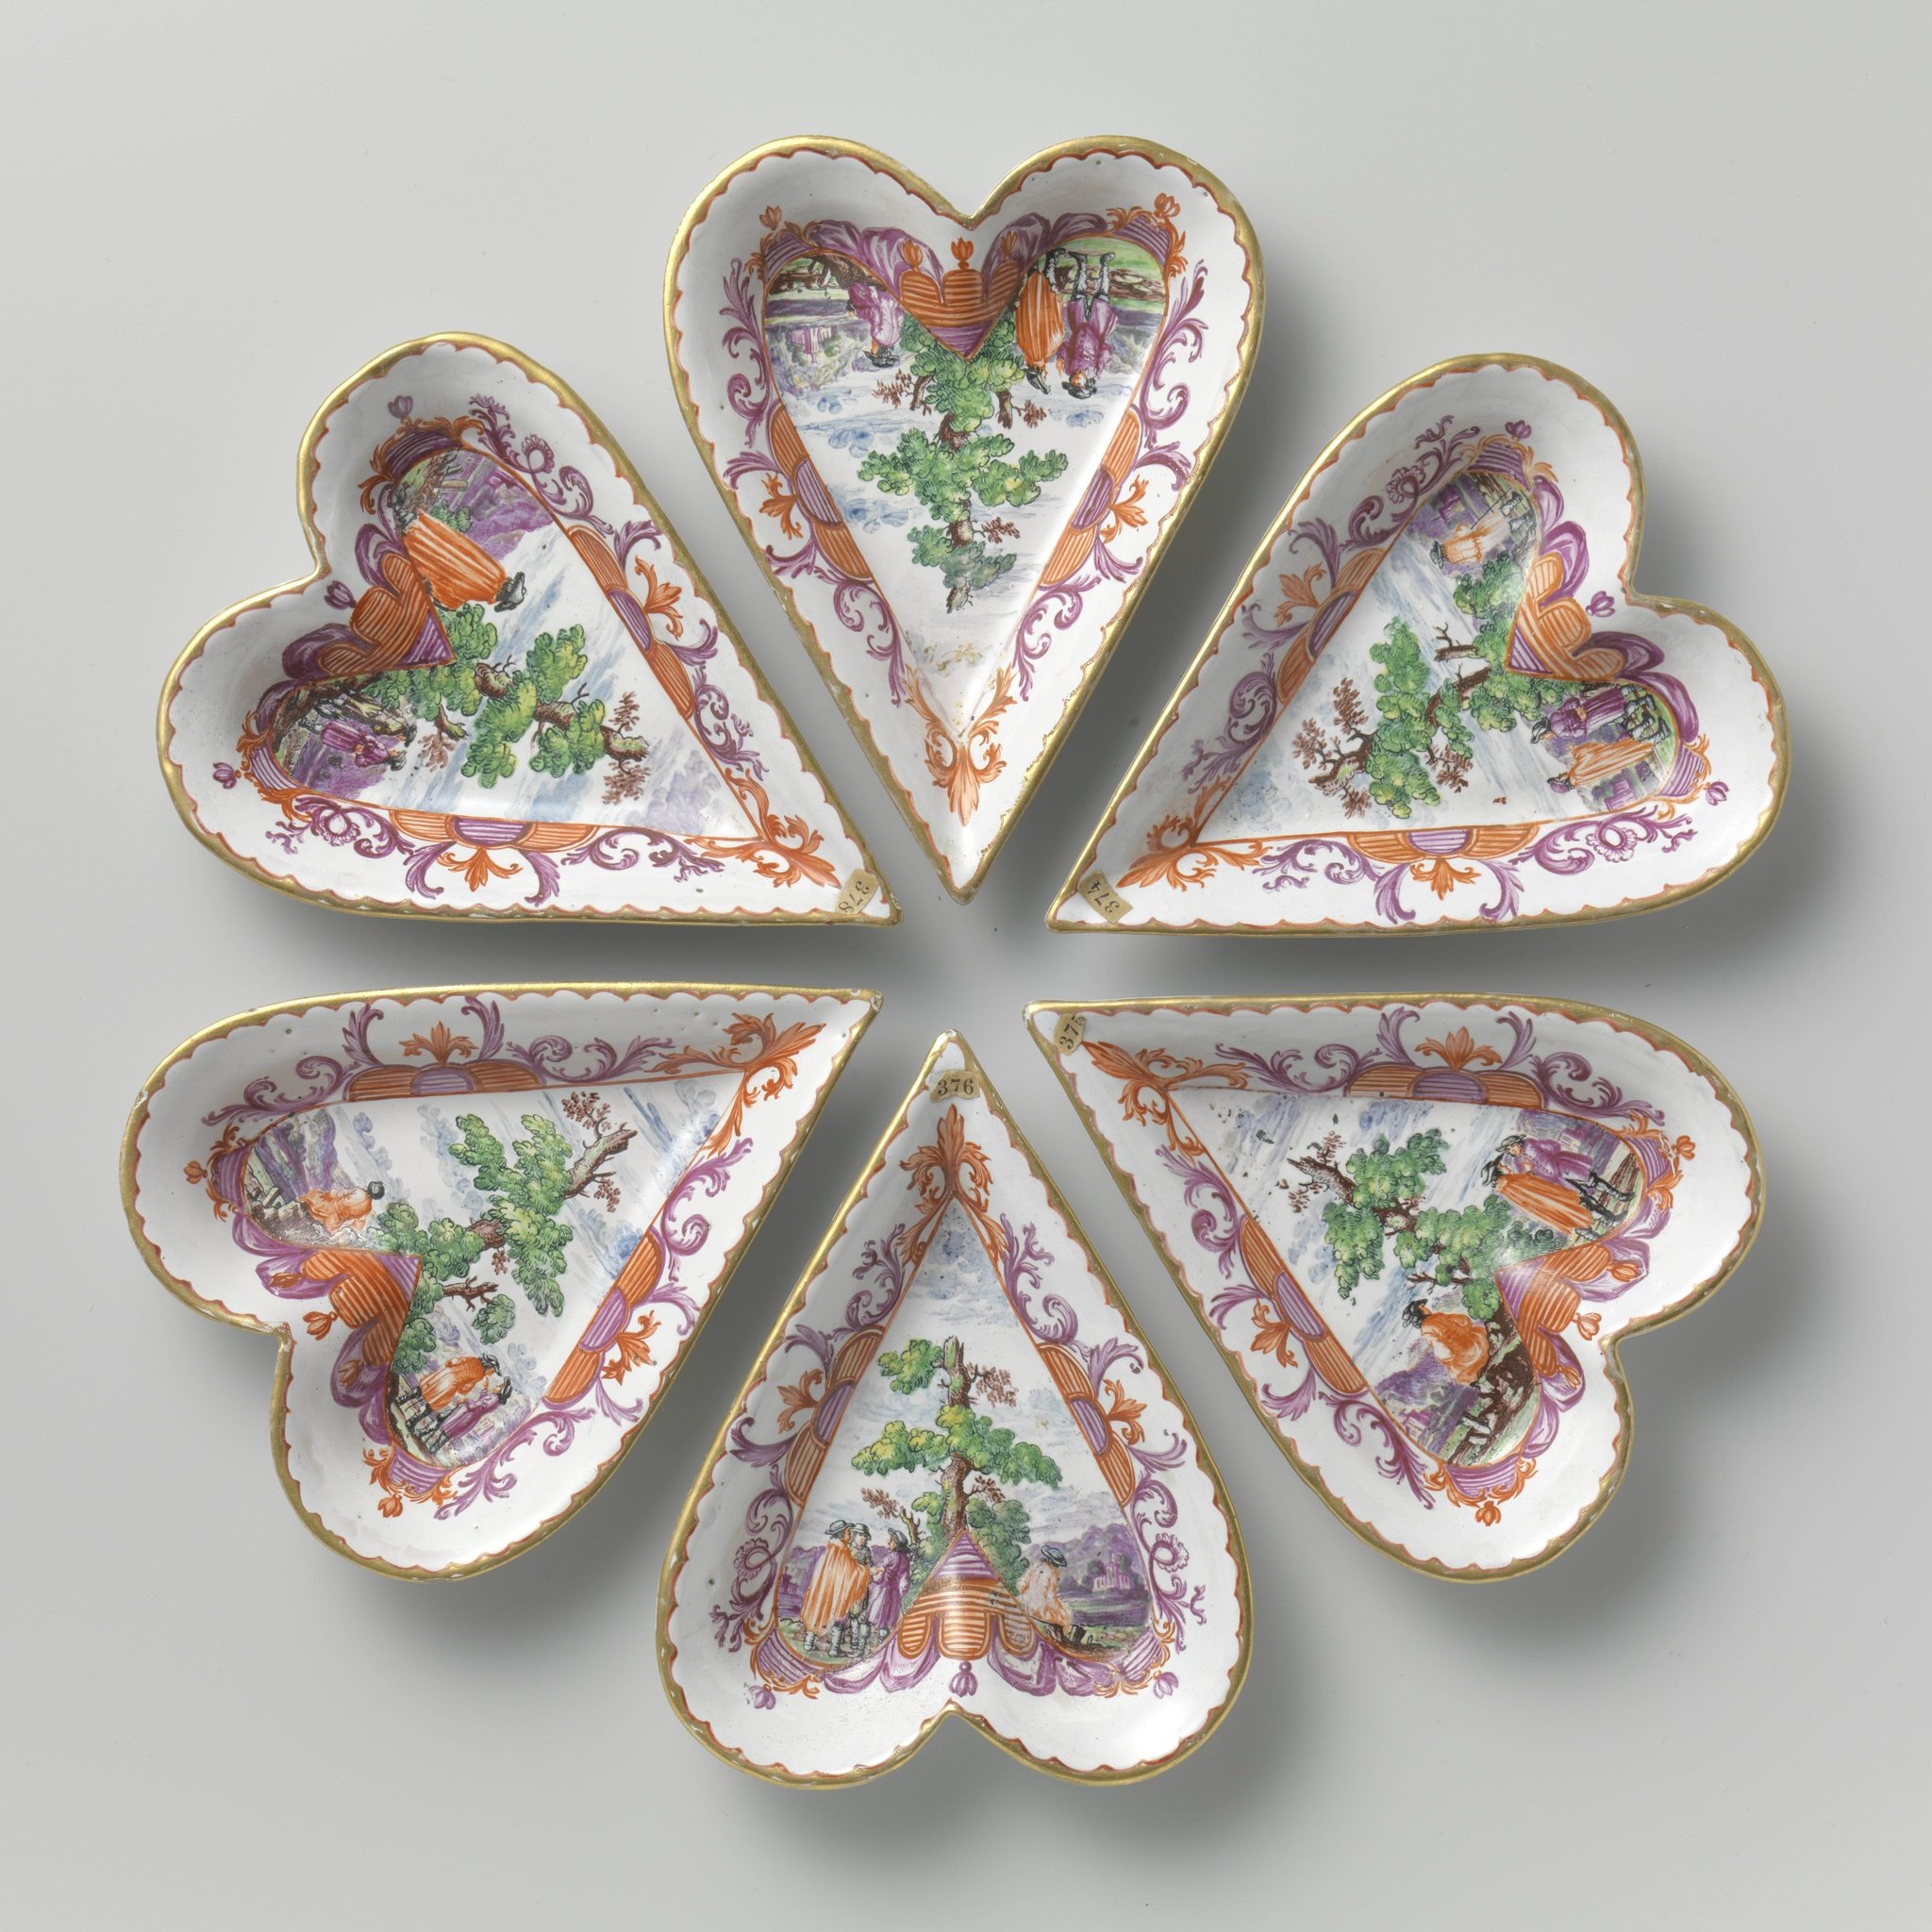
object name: dish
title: Set of six small heart-shaped dishes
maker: Anonymous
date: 1735-1755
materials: earthenware, glaze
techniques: kiln, painted, polychromy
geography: delft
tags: trees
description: Delft, c. 1735–1755 tin-glazed earthenware (faience)